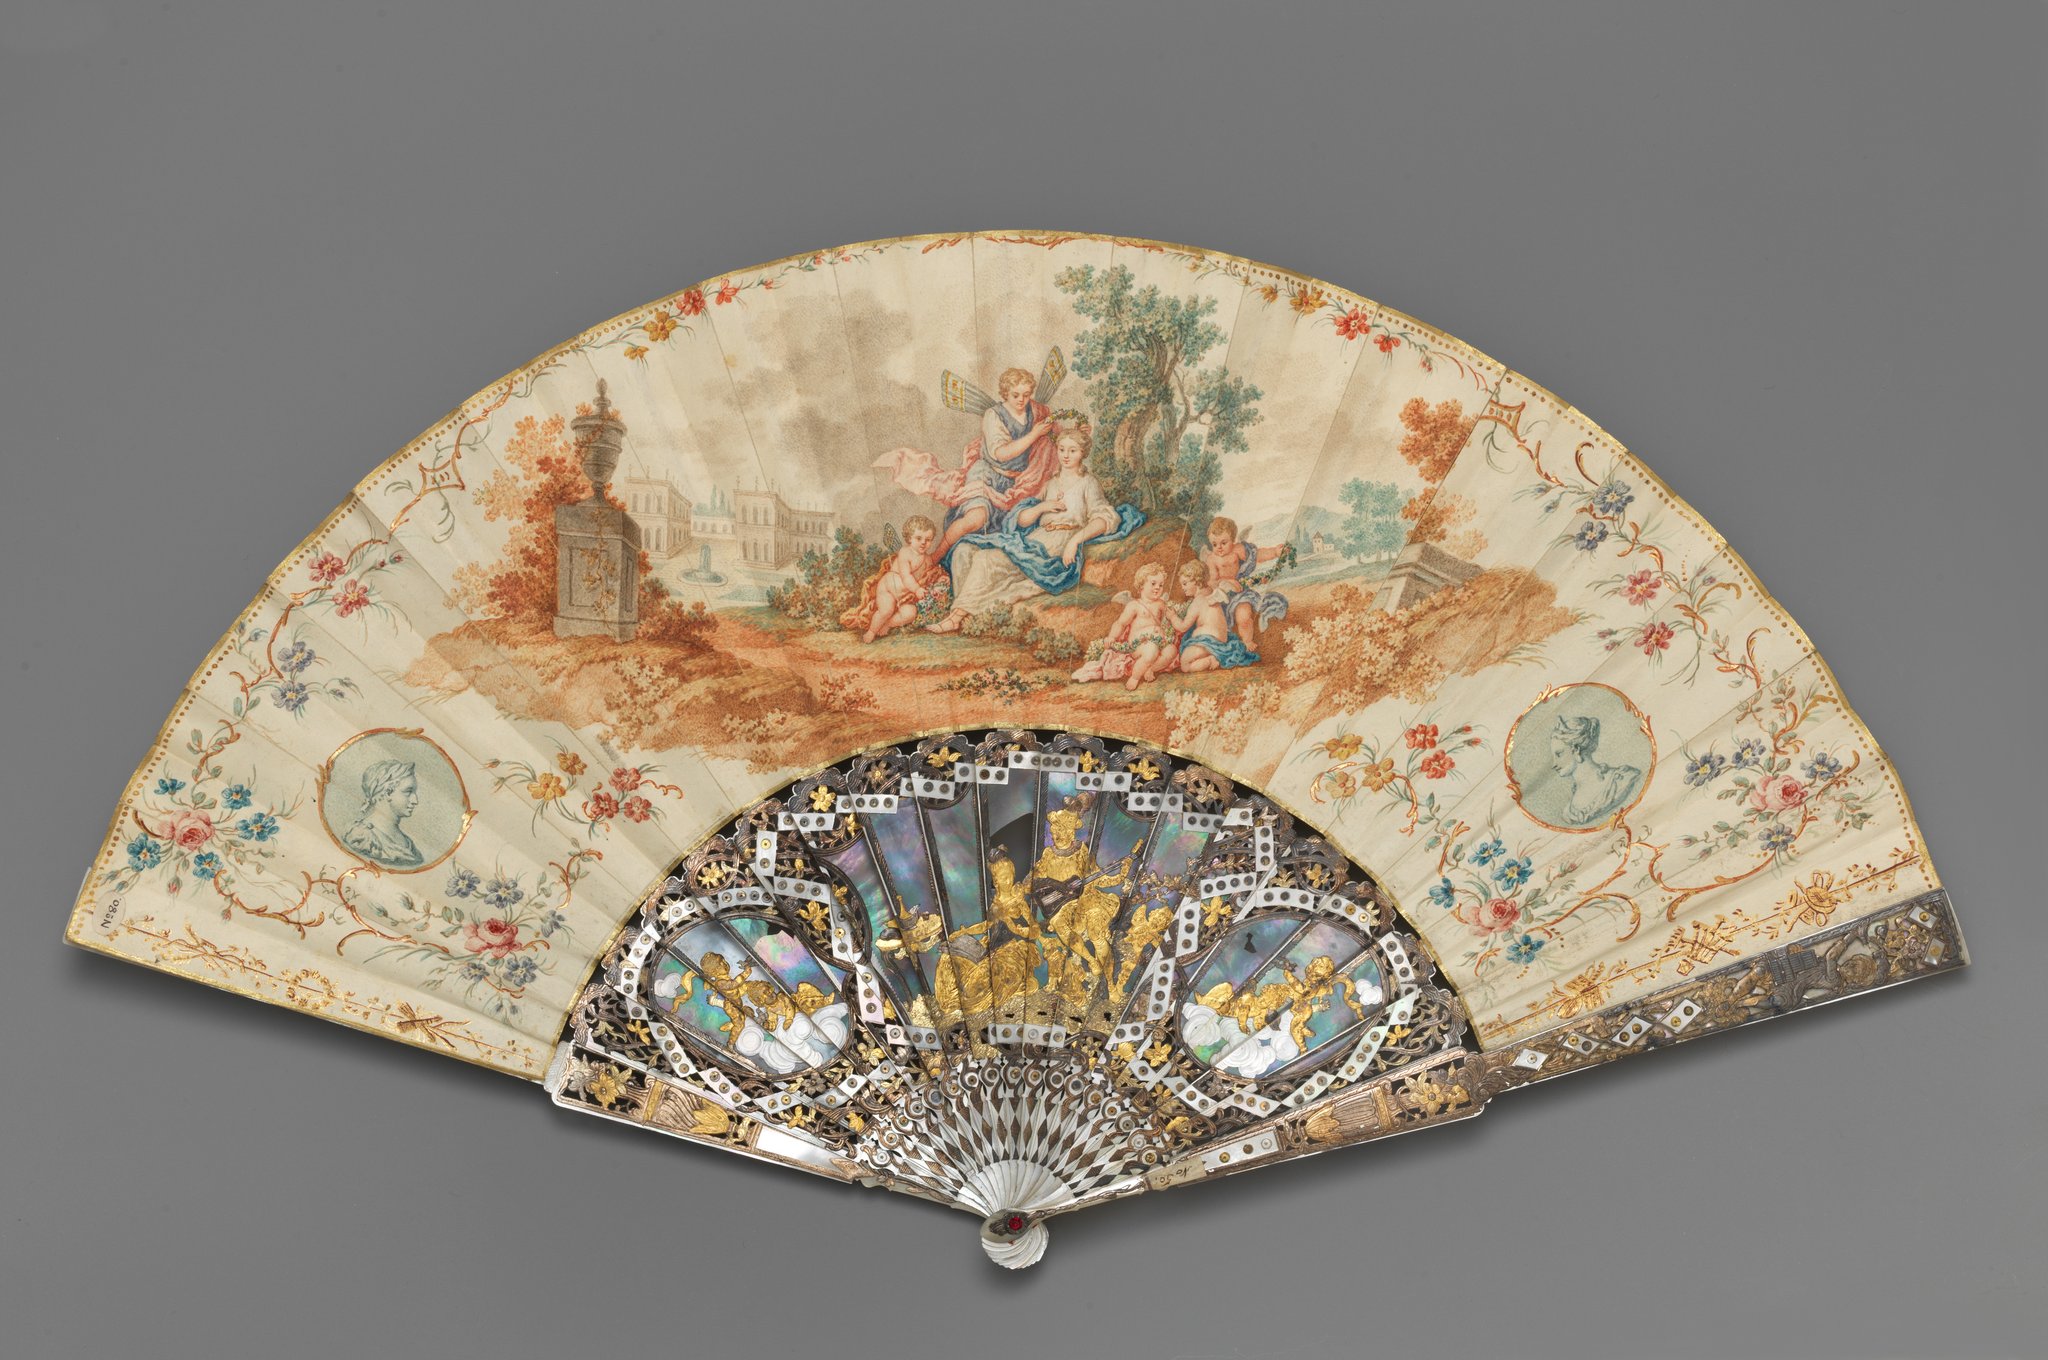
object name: fan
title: Fan depicting Psyche crowning a maiden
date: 1760-1790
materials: foil, glass, metal, mother of pearl, paper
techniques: carving, painting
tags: men,women,cupid,psyche